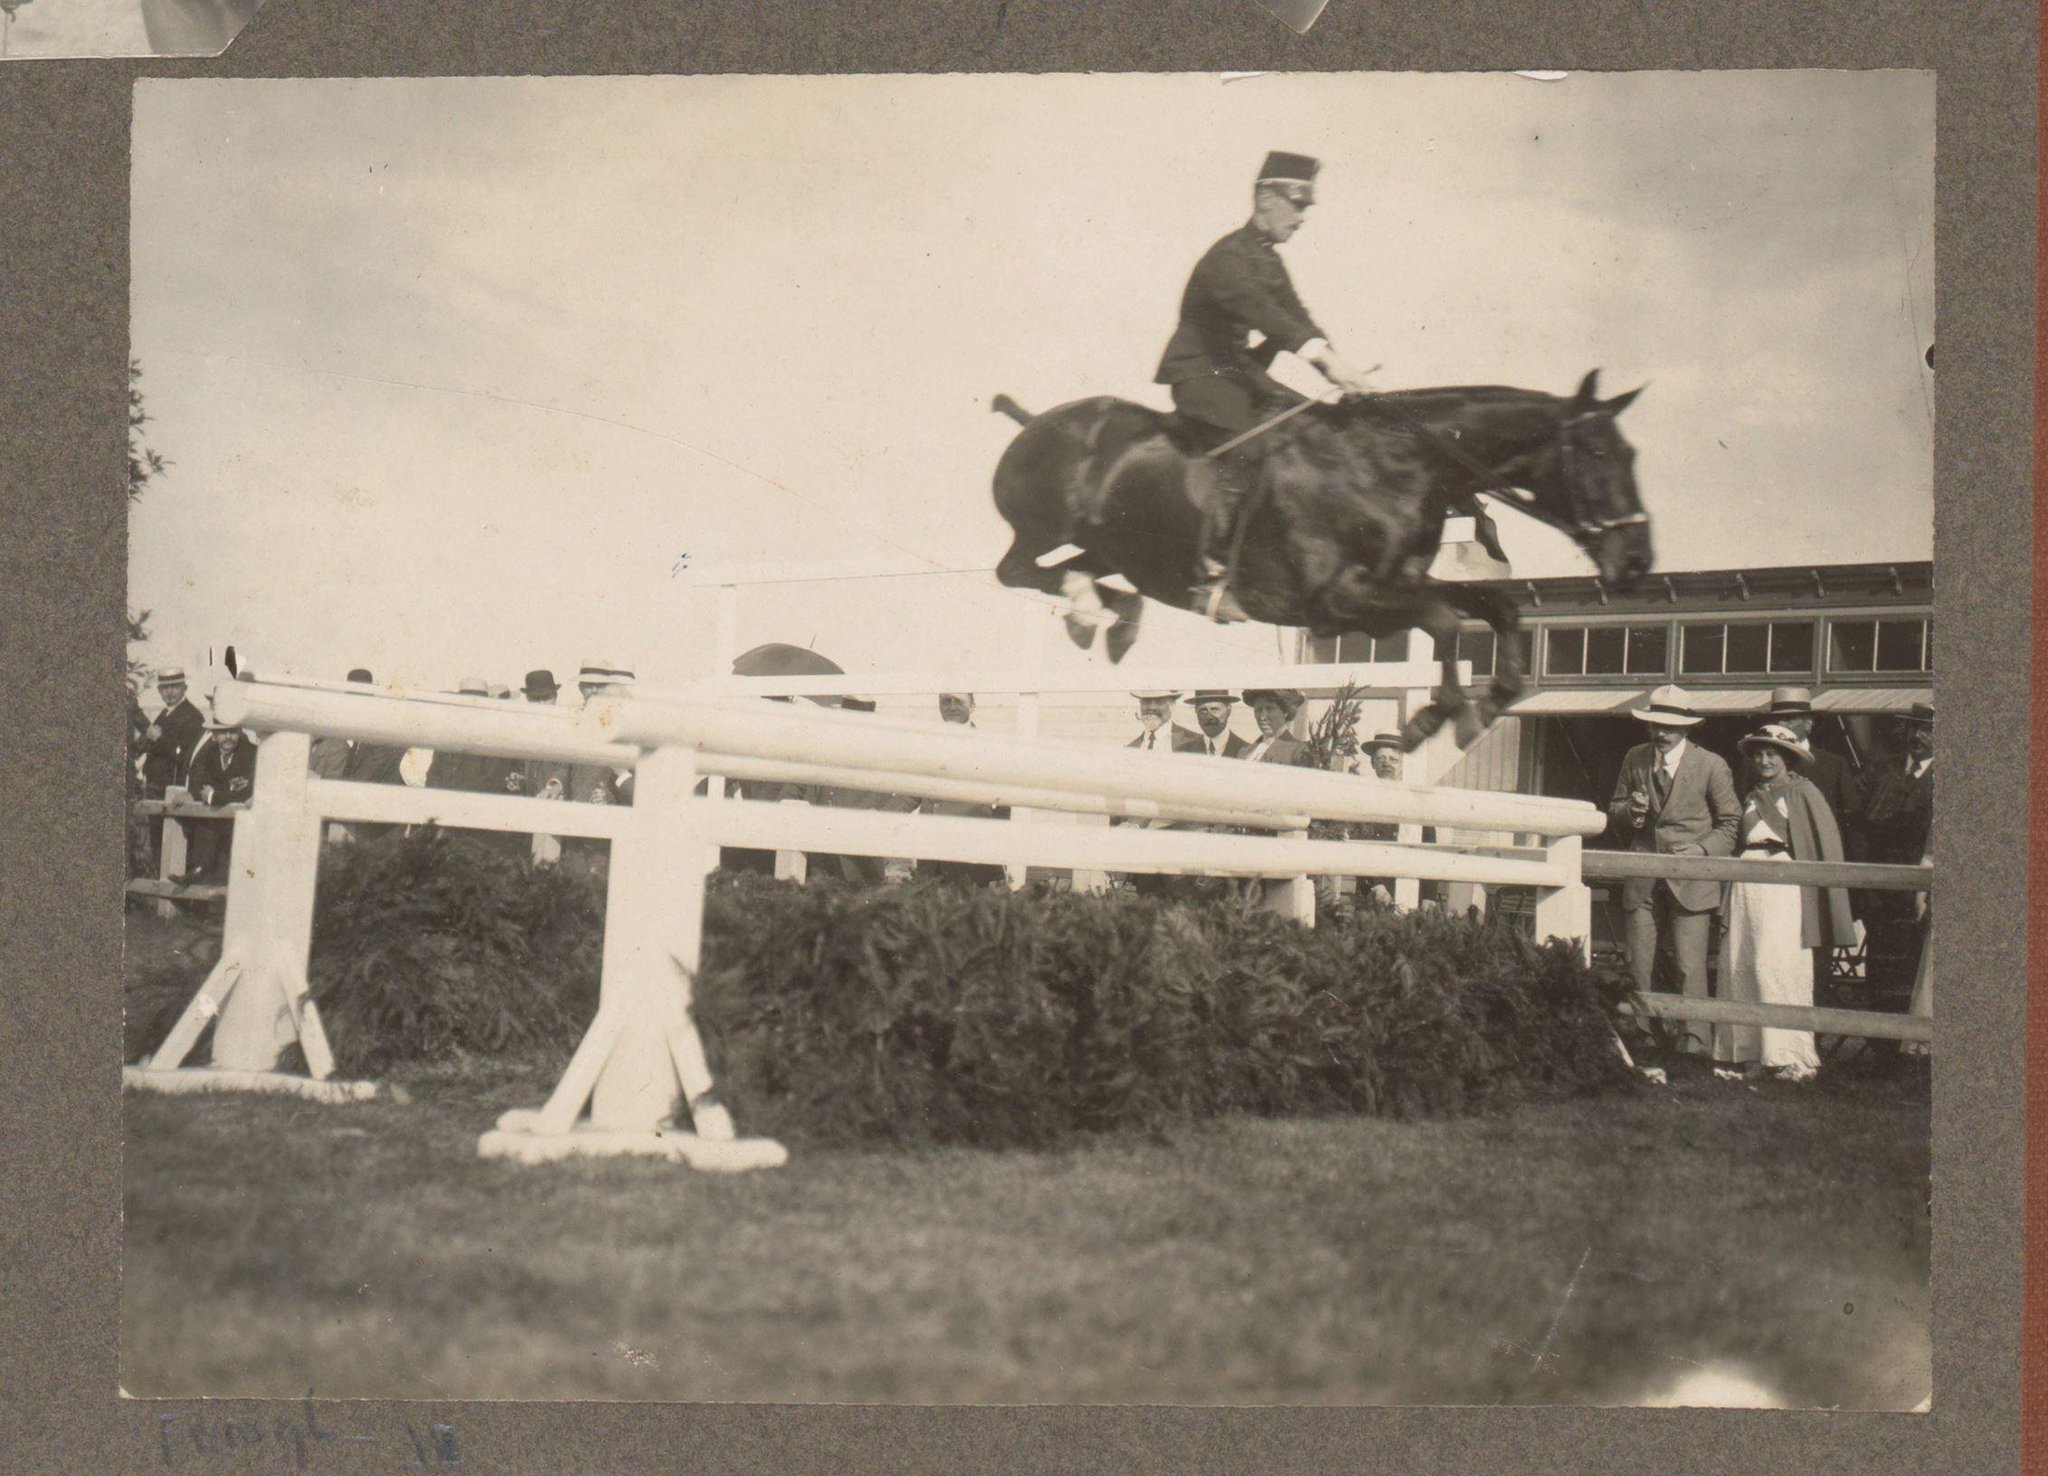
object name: album leaf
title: Ruitertafereel op Koninklijke Houtvesterij Het Loo: geüniformeerde ruiter neemt hindernis op een renbaan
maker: Anonymous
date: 1900-1925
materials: photographic support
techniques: gelatin silver print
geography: het loo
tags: riding a horse, ass, or mule; rider, horseman, hunting, chase, hunting-ground, horse-racing, jumping (horse in motion)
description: Onderdeel van Fotoalbum van de heer Brams, opperhoutvester van koningin Wilhelmina op Koninklijke Houtvesterij Het Loo.